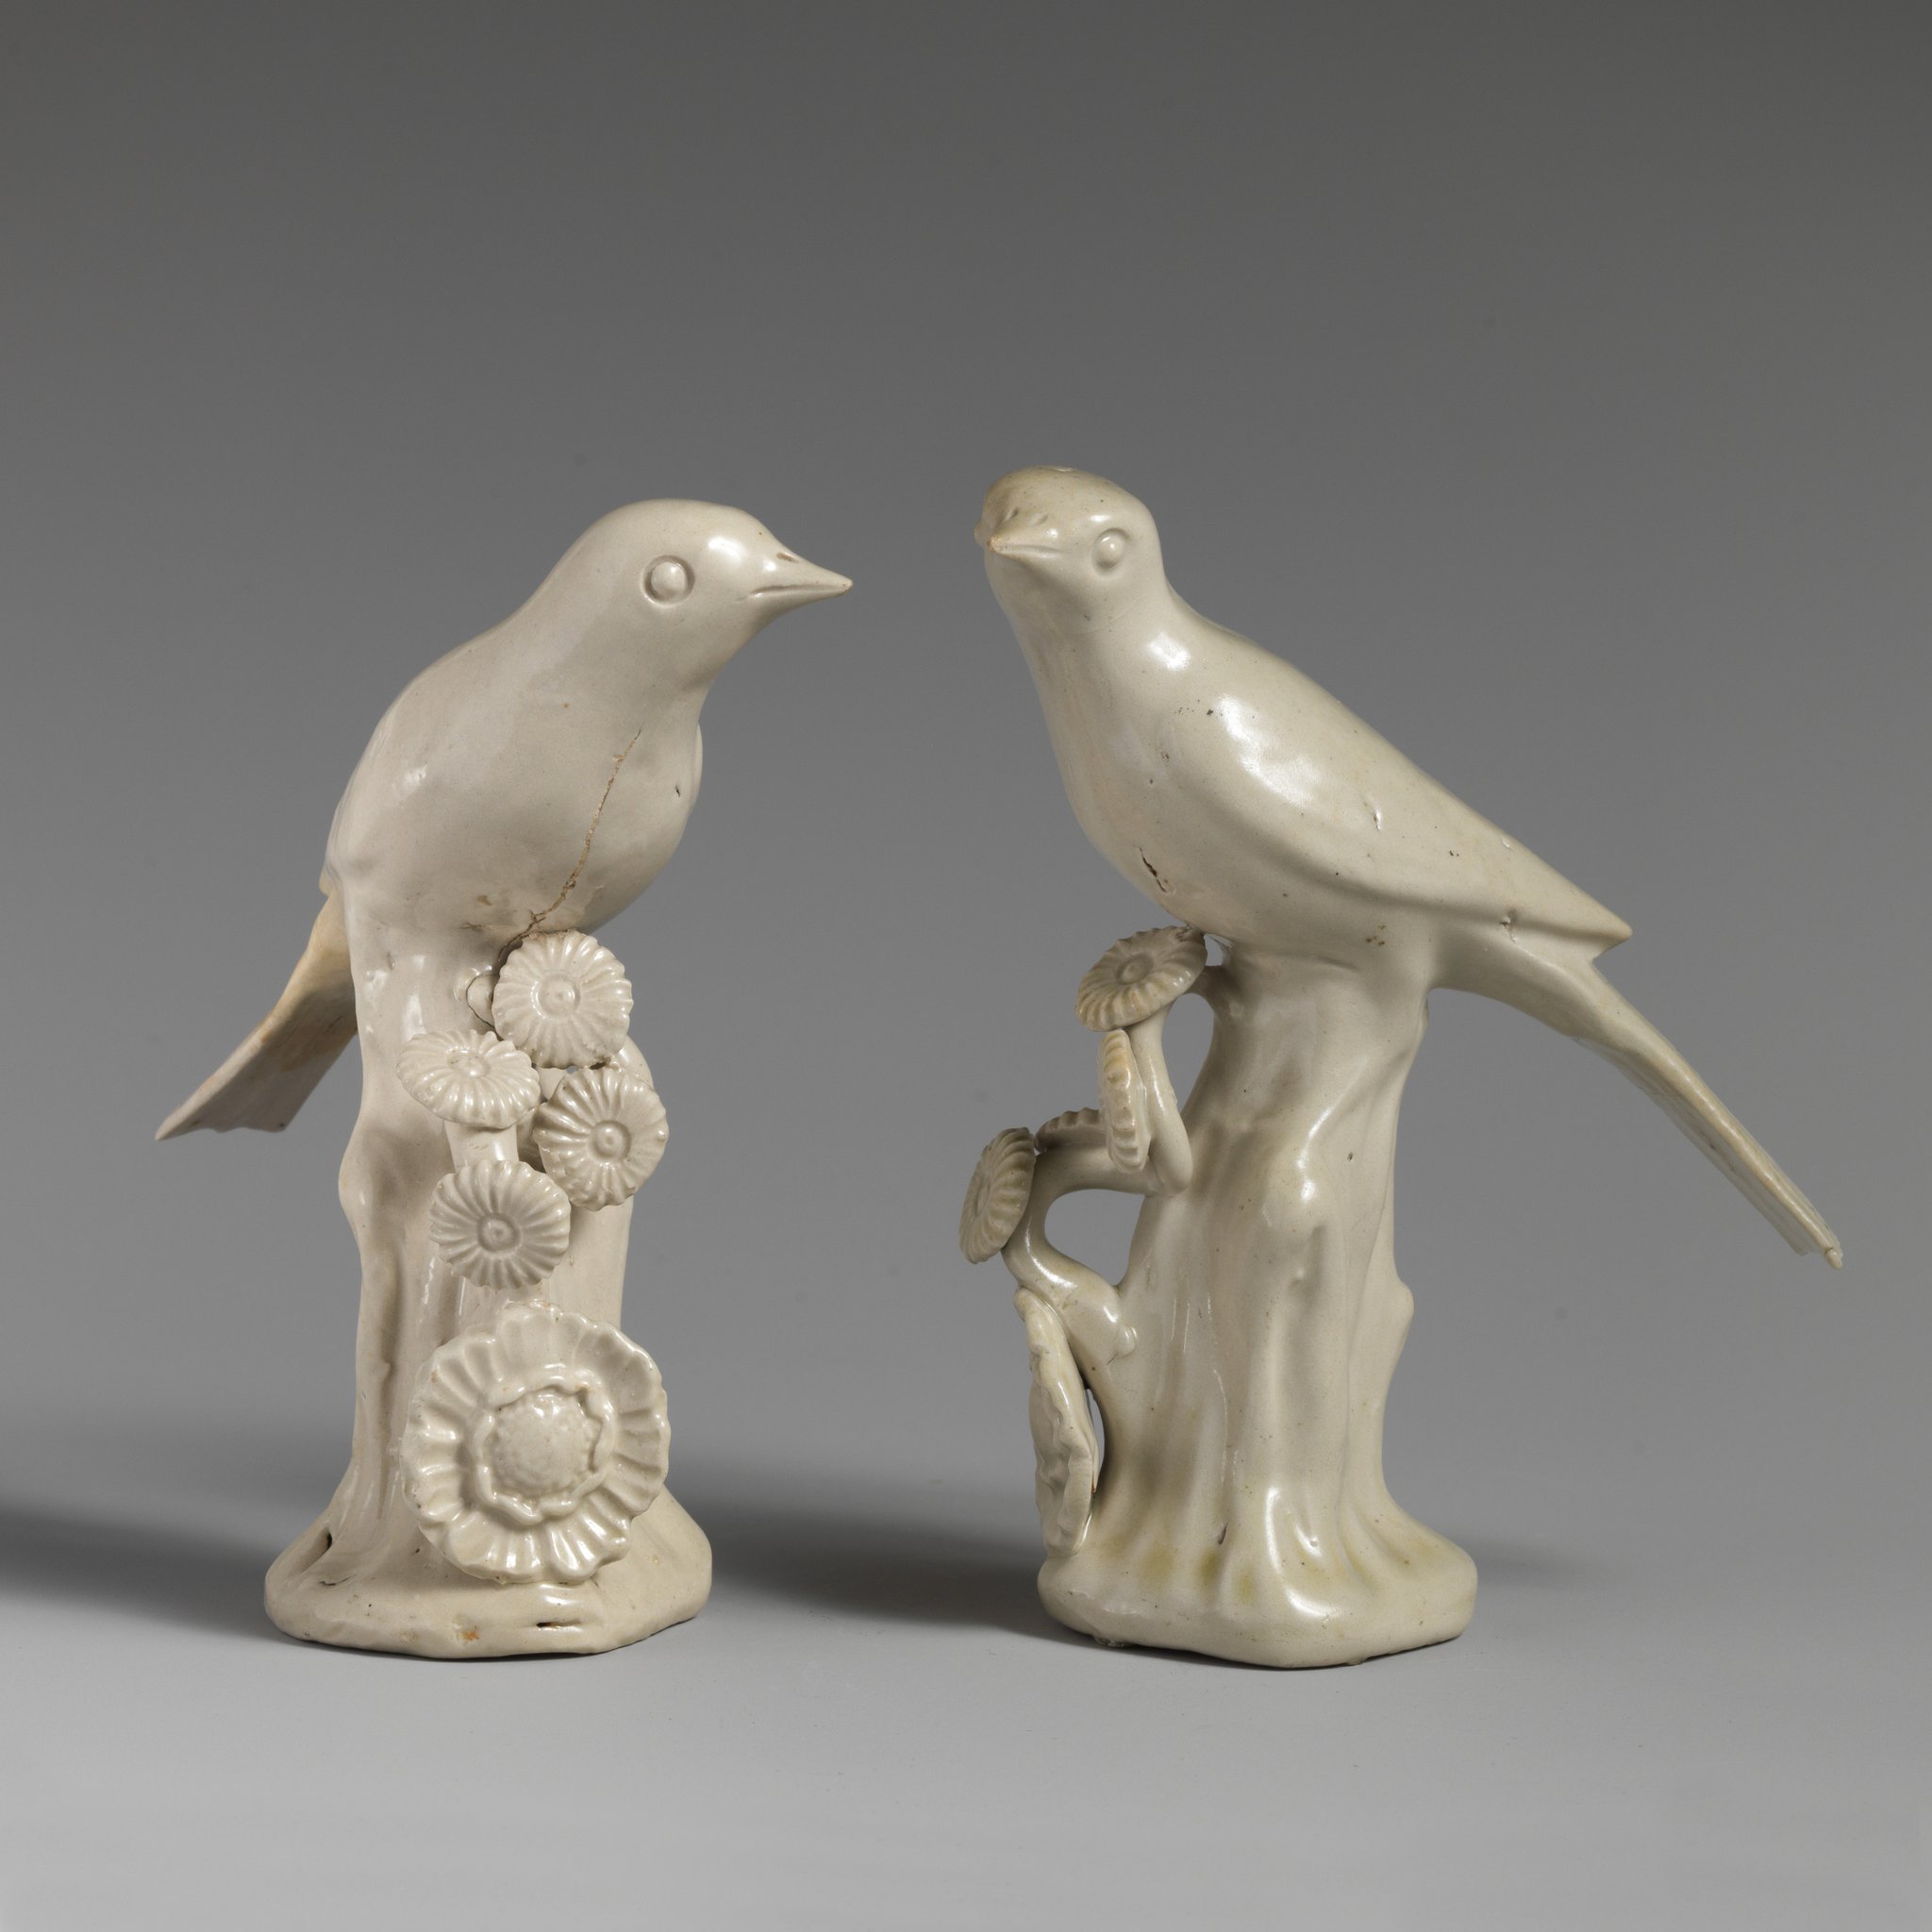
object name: figure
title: Pair of birds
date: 1750-1755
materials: stoneware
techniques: salt glaze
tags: birds,flowers